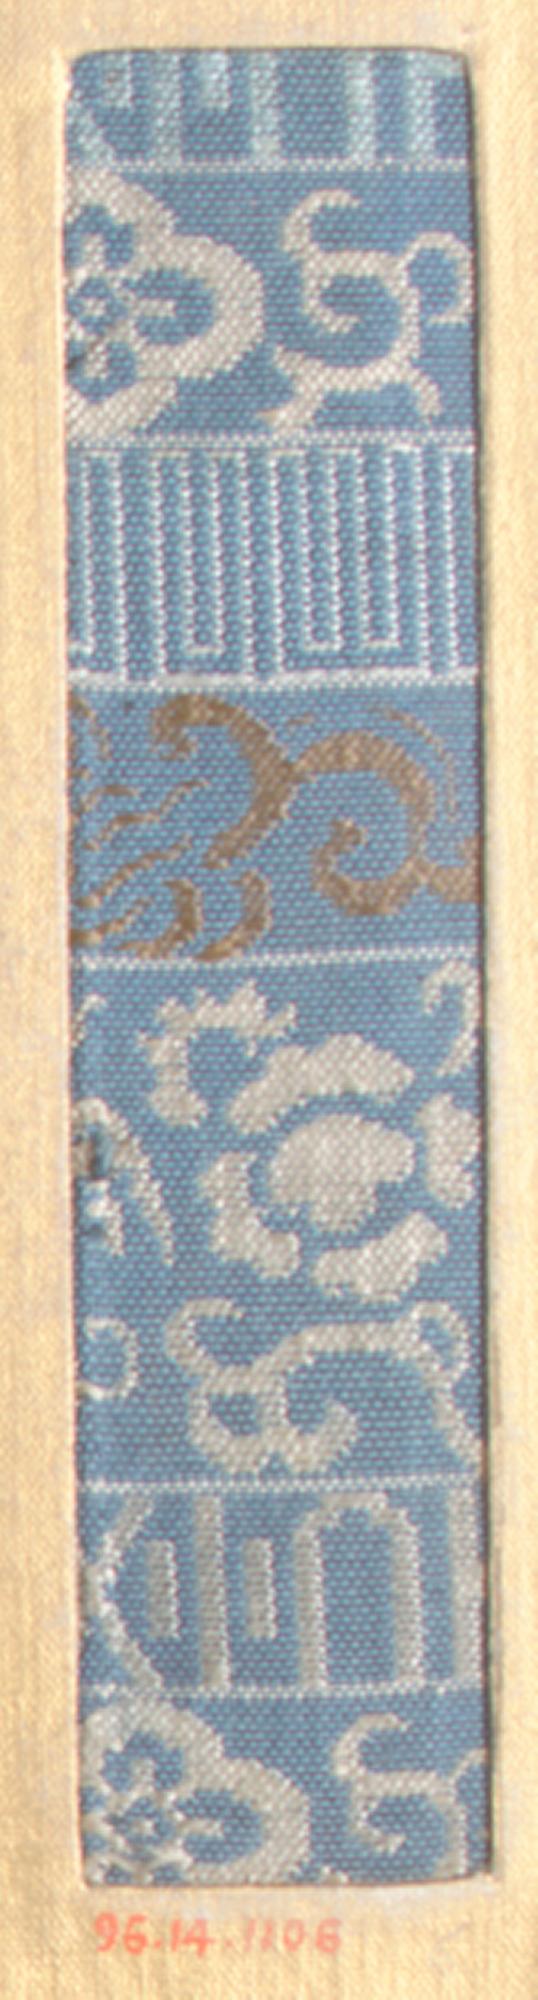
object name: piece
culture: japanese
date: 1701-1900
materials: silk